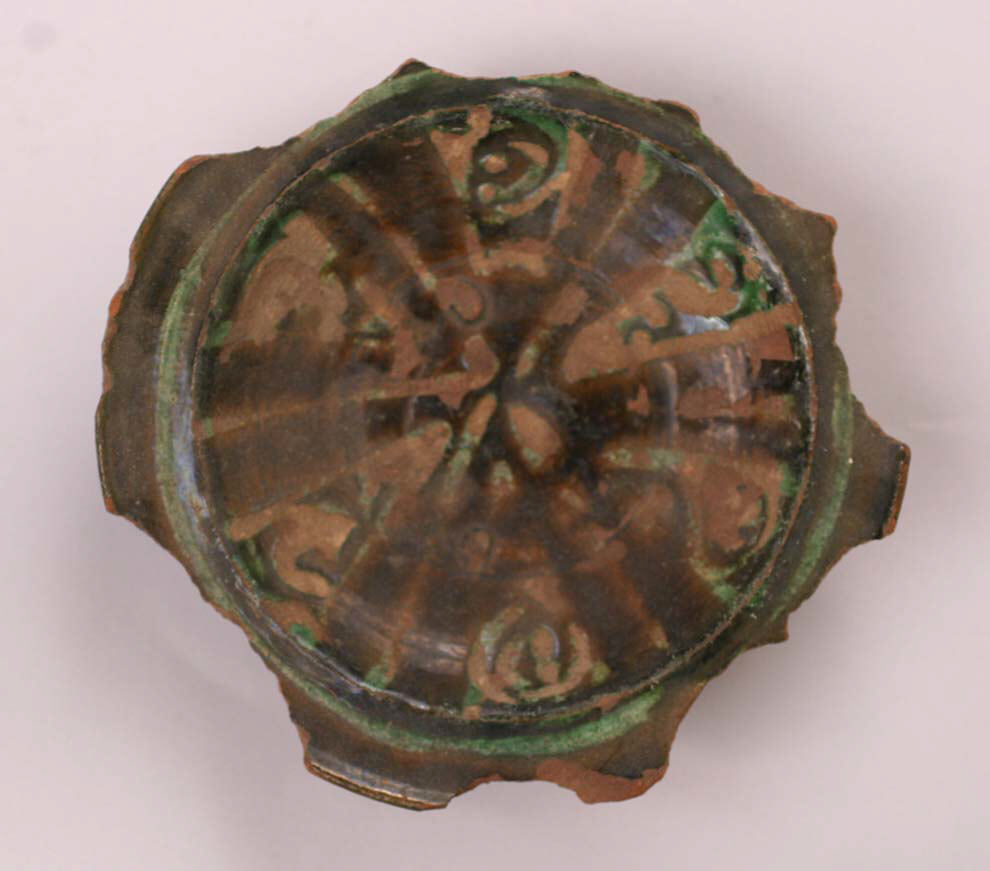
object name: fragment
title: Fragment of a Bowl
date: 1301-1500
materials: earthenware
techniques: glazing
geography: egypt